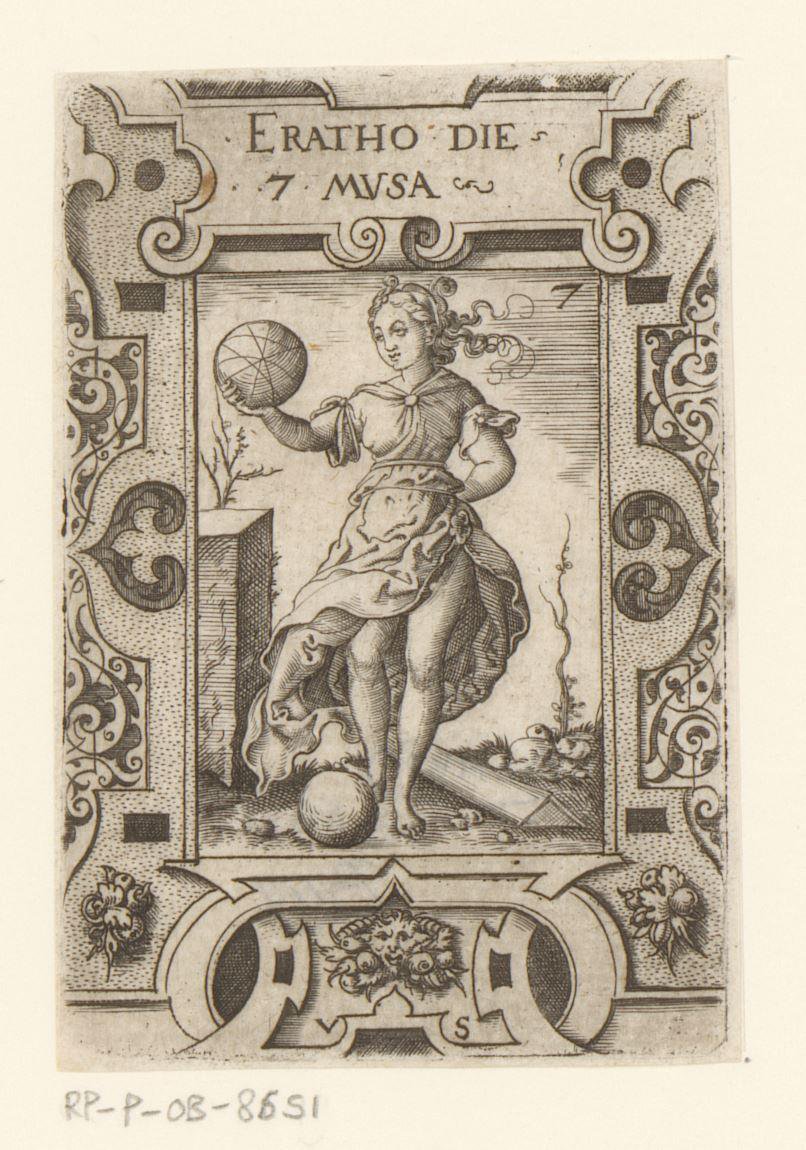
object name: print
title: Erato in rolwerk omlijsting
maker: virgilius solis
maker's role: draughtsman, print maker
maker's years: 1514-1562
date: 1524-1562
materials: paper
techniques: engraving, etching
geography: nuremberg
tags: erato (one of the muses); 'erato' (ripa)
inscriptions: collector's mark: Lugt 2228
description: Prent maakt deel uit van een serie bestaande uit negen prenten met de muzen.